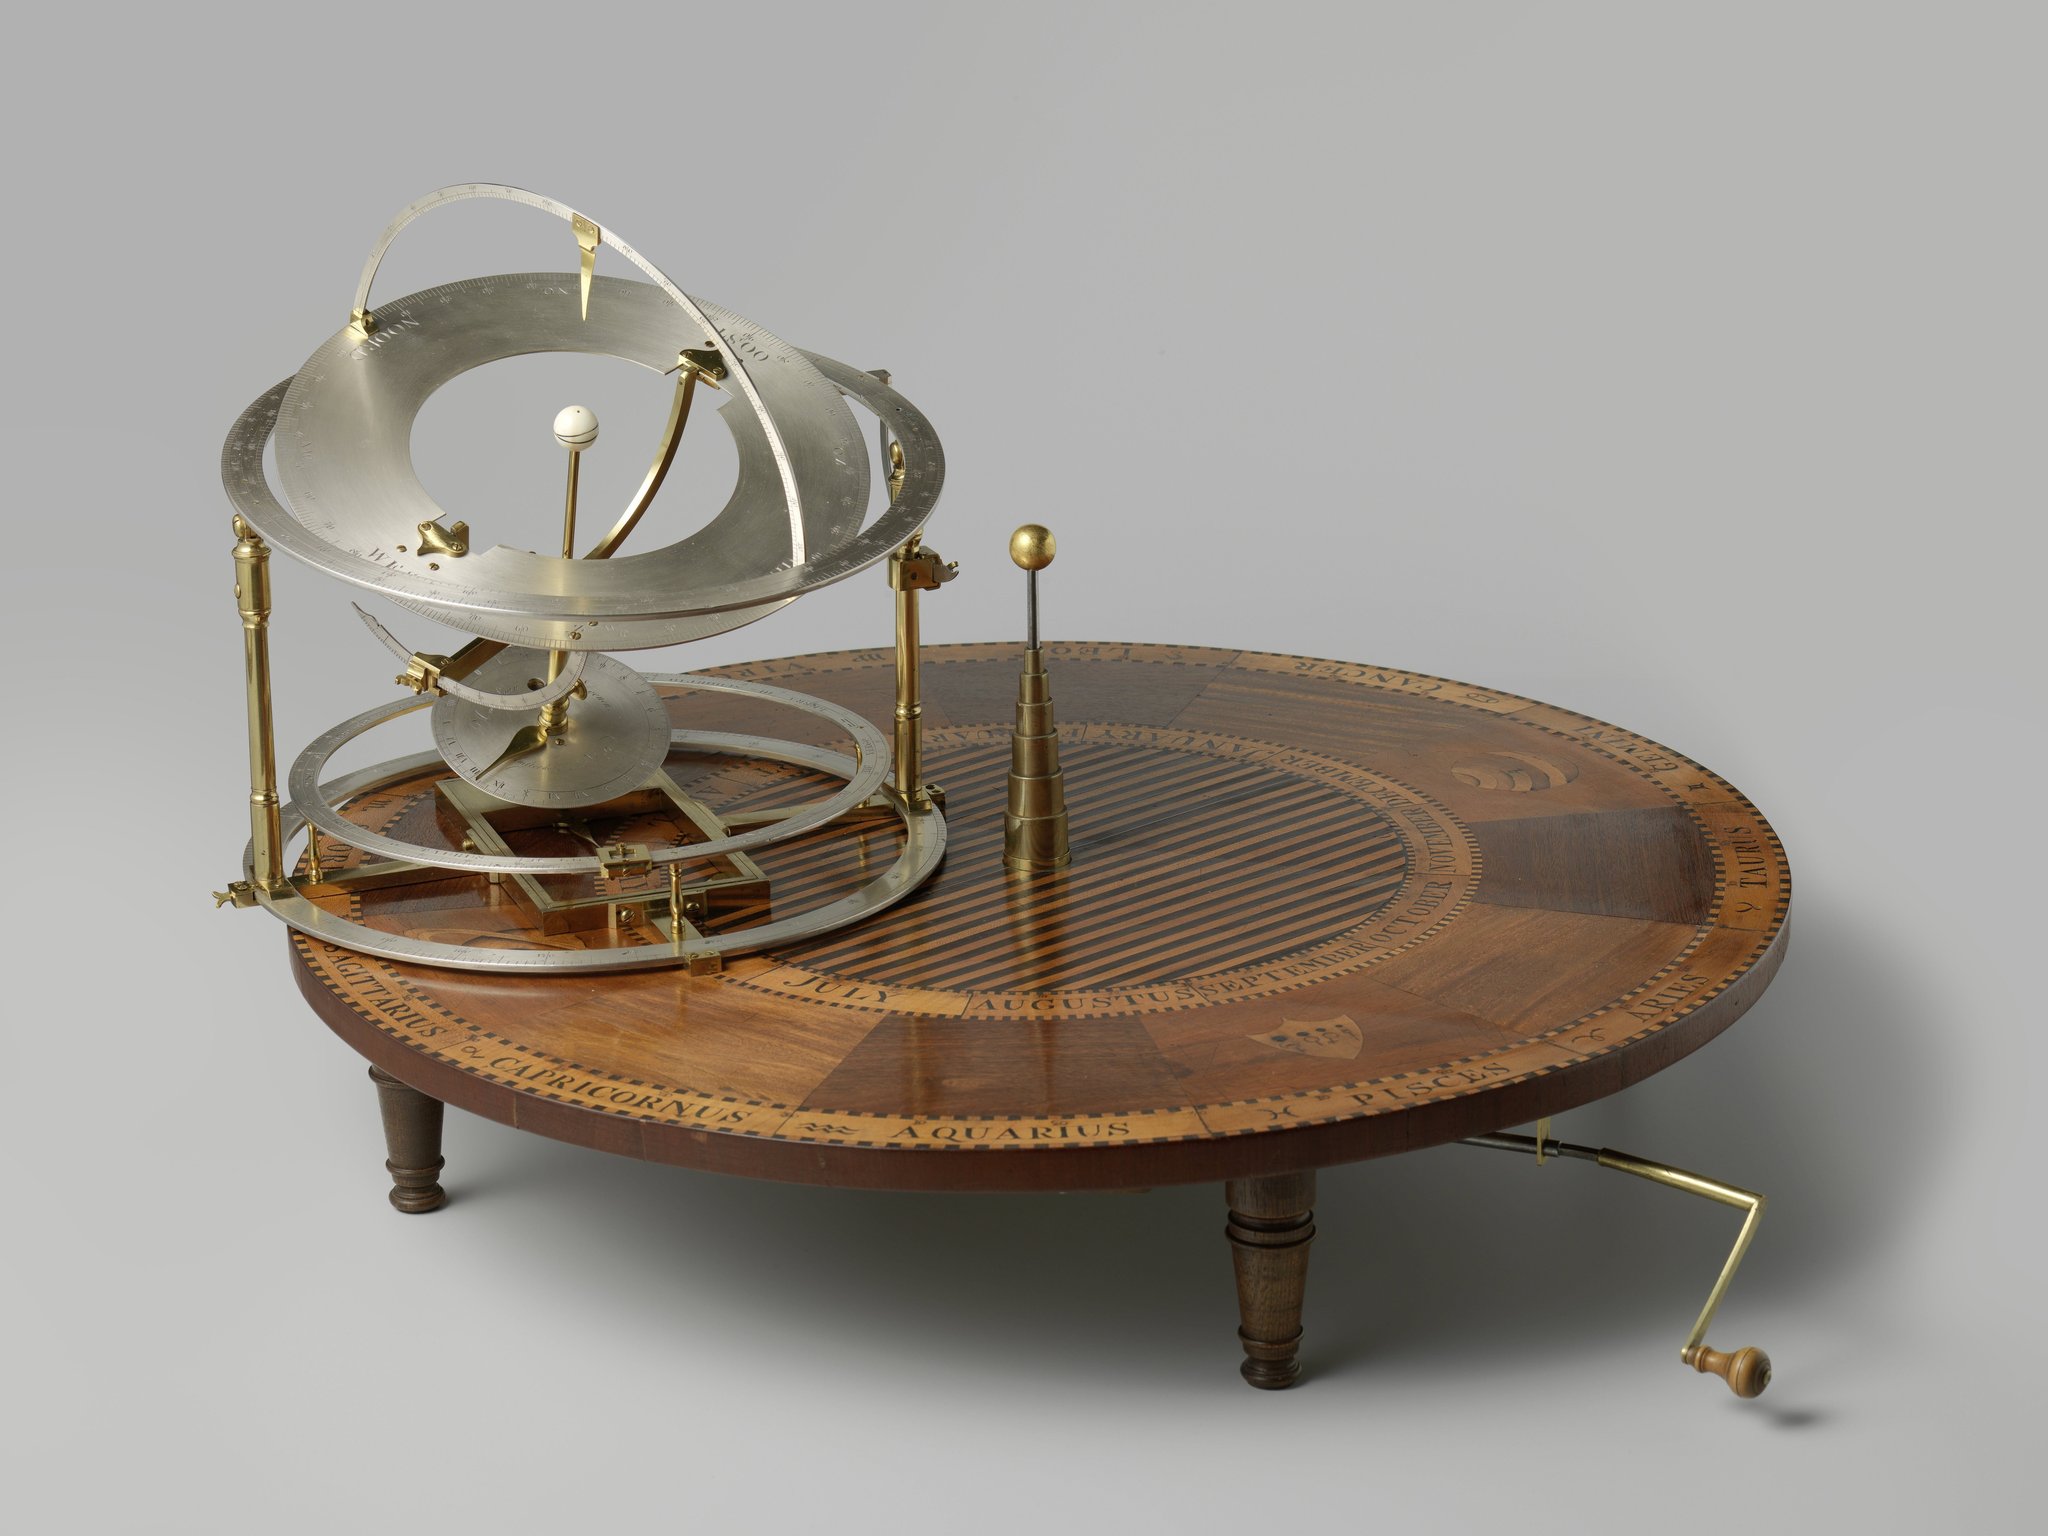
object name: lunarium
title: Table orrery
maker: hartog van laun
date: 1800-1808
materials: brass, ivory, wood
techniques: gilding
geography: amsterdam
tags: amsterdam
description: The instrument-maker Hartog van Laun designed a table orrery – a mechanical device to show the relative positions and movements of the sun, earth, moon and planets. He used the instrument for his own lectures, but he achieved true success with it only when the Amsterdam professor Jan Hendrik van Swinden fully explained it at the Felix Meritis Society in 1802 and published articles about it.